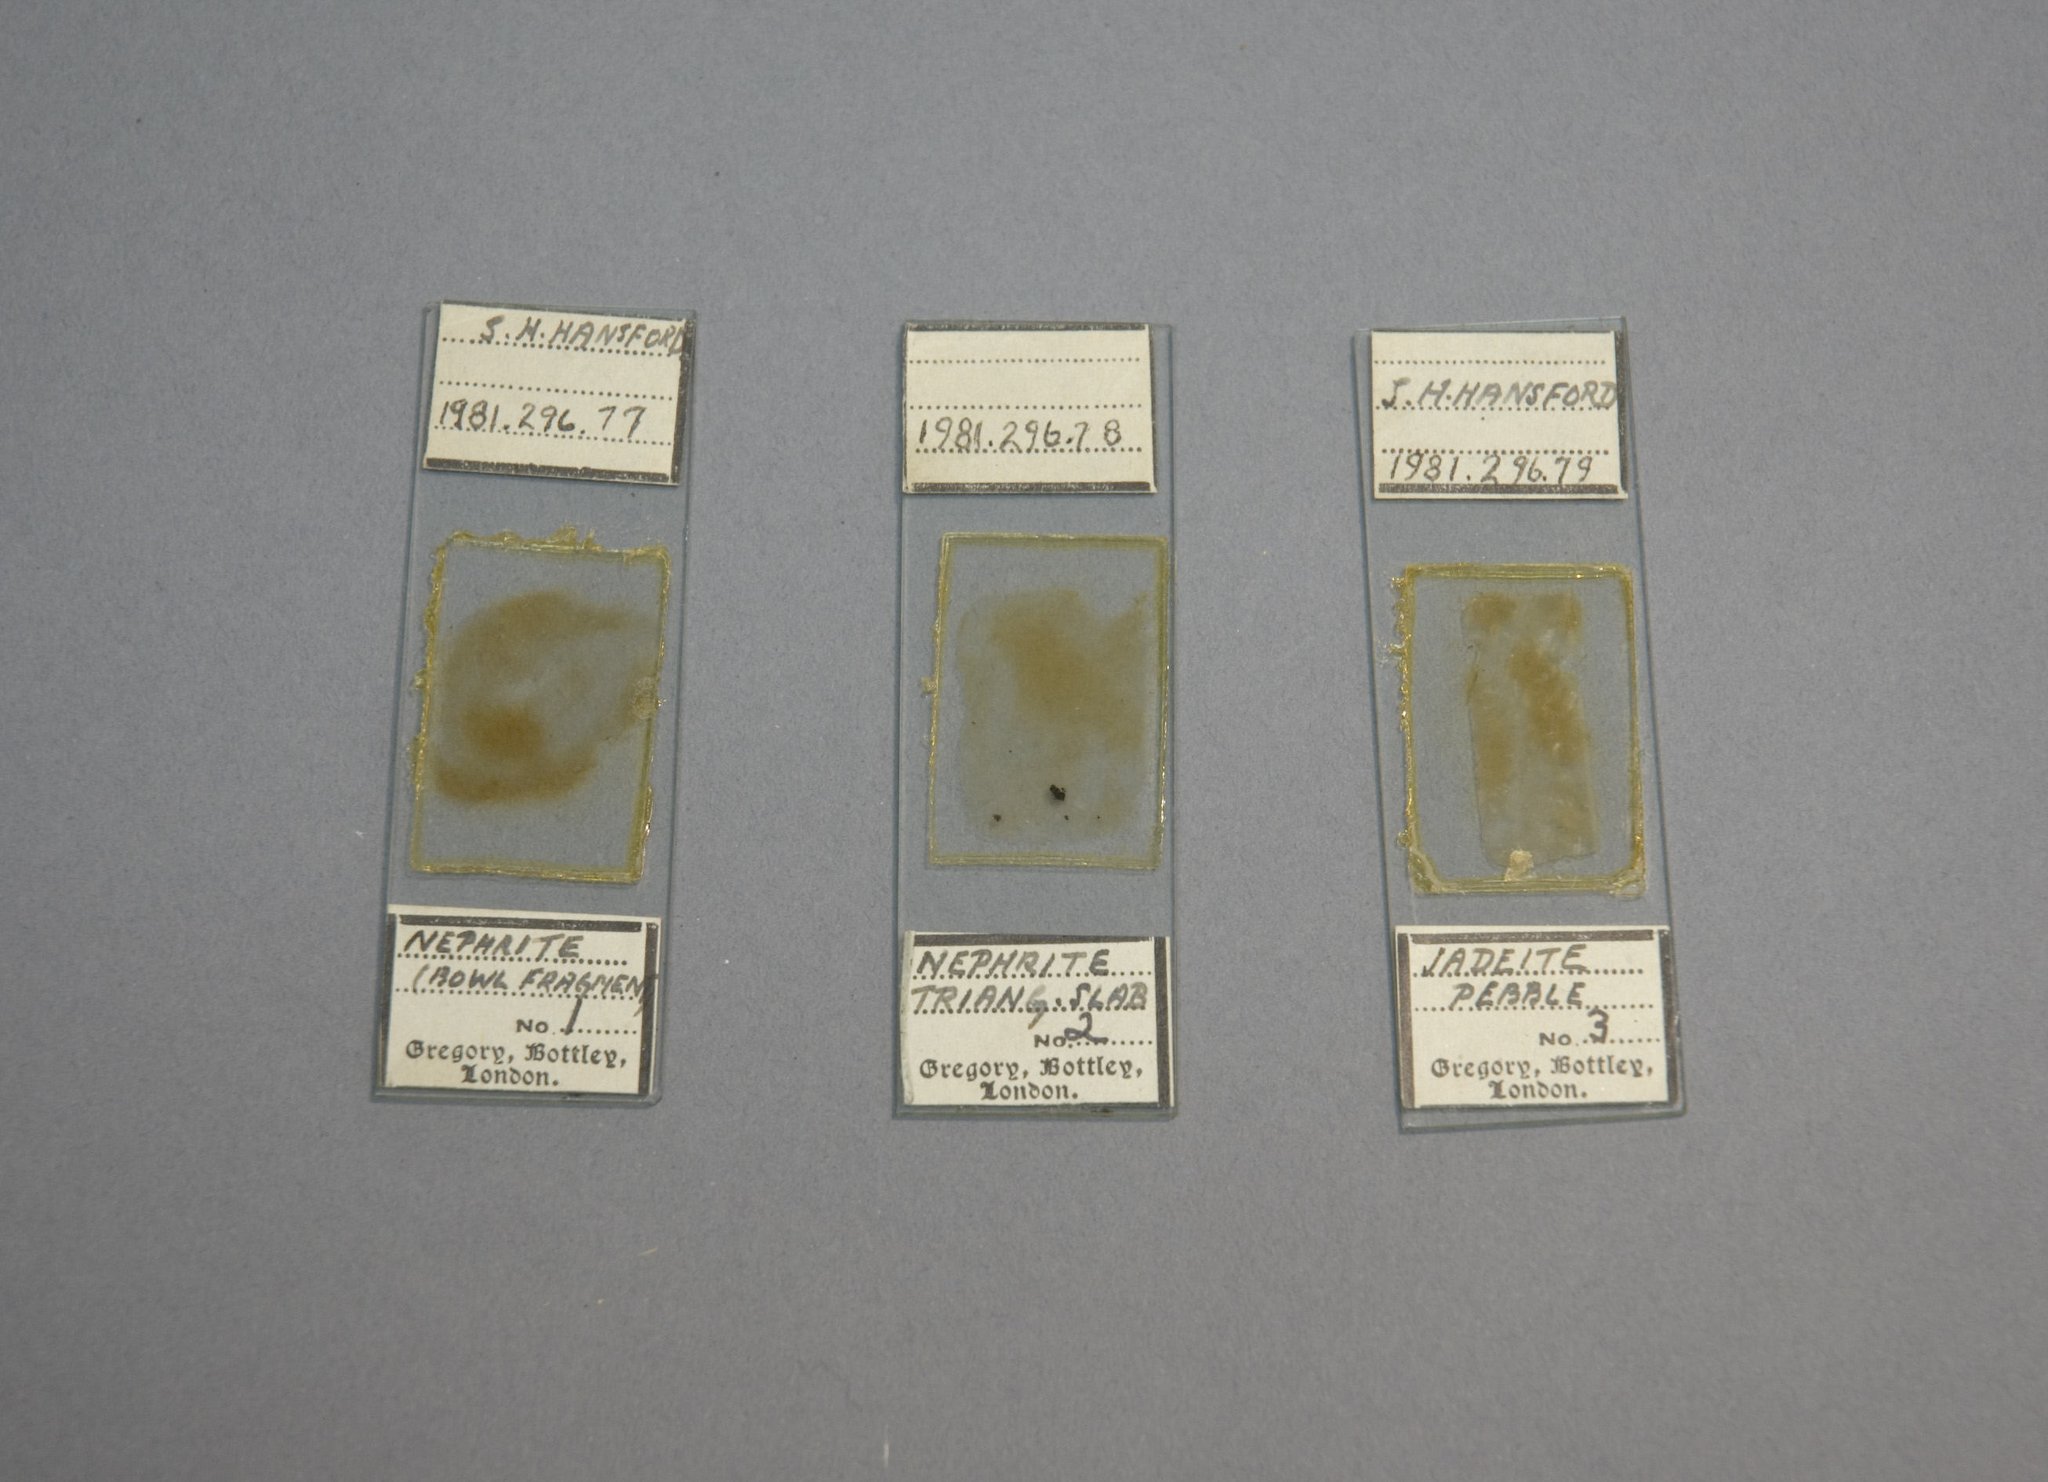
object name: jade carving material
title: Thin Section of Jadeite Mounted in a Microscope Slide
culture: chinese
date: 1901-2000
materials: jade